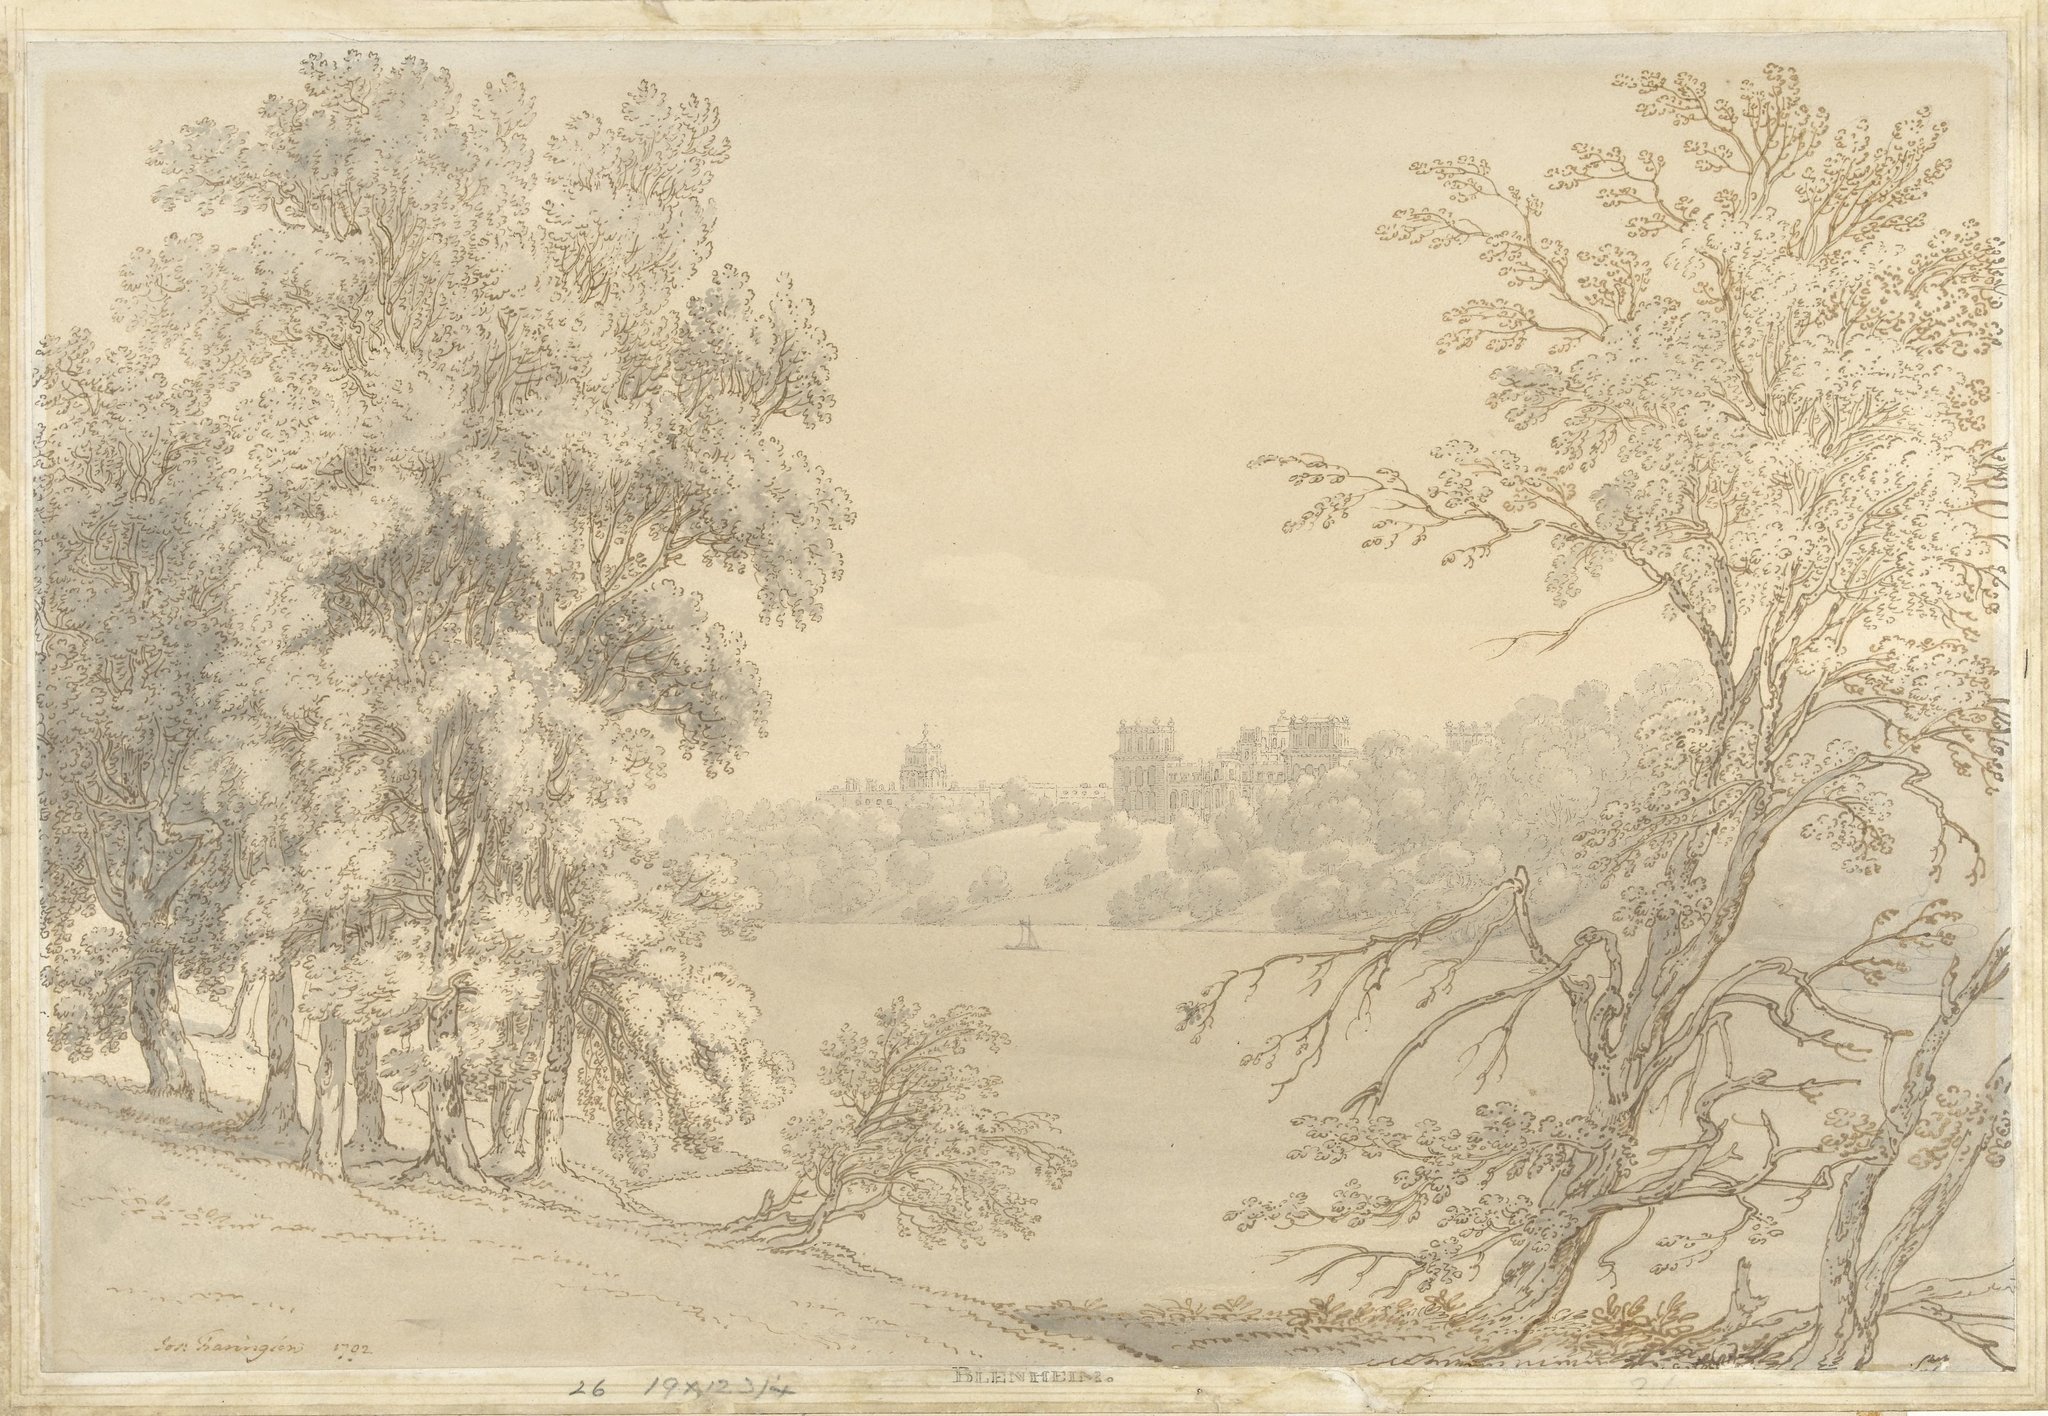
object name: design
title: Gezicht op Blenheim Palace over het meer Blenheim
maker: joseph farington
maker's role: draughtsman, print maker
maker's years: 1747-1821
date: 1792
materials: ink, paper, pencil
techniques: brush, pen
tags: park, garden, palace, landscape with tower or castle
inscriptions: signature: ‘Jos. Farington’, inscription: ‘Blenheim’, date: ‘1792’